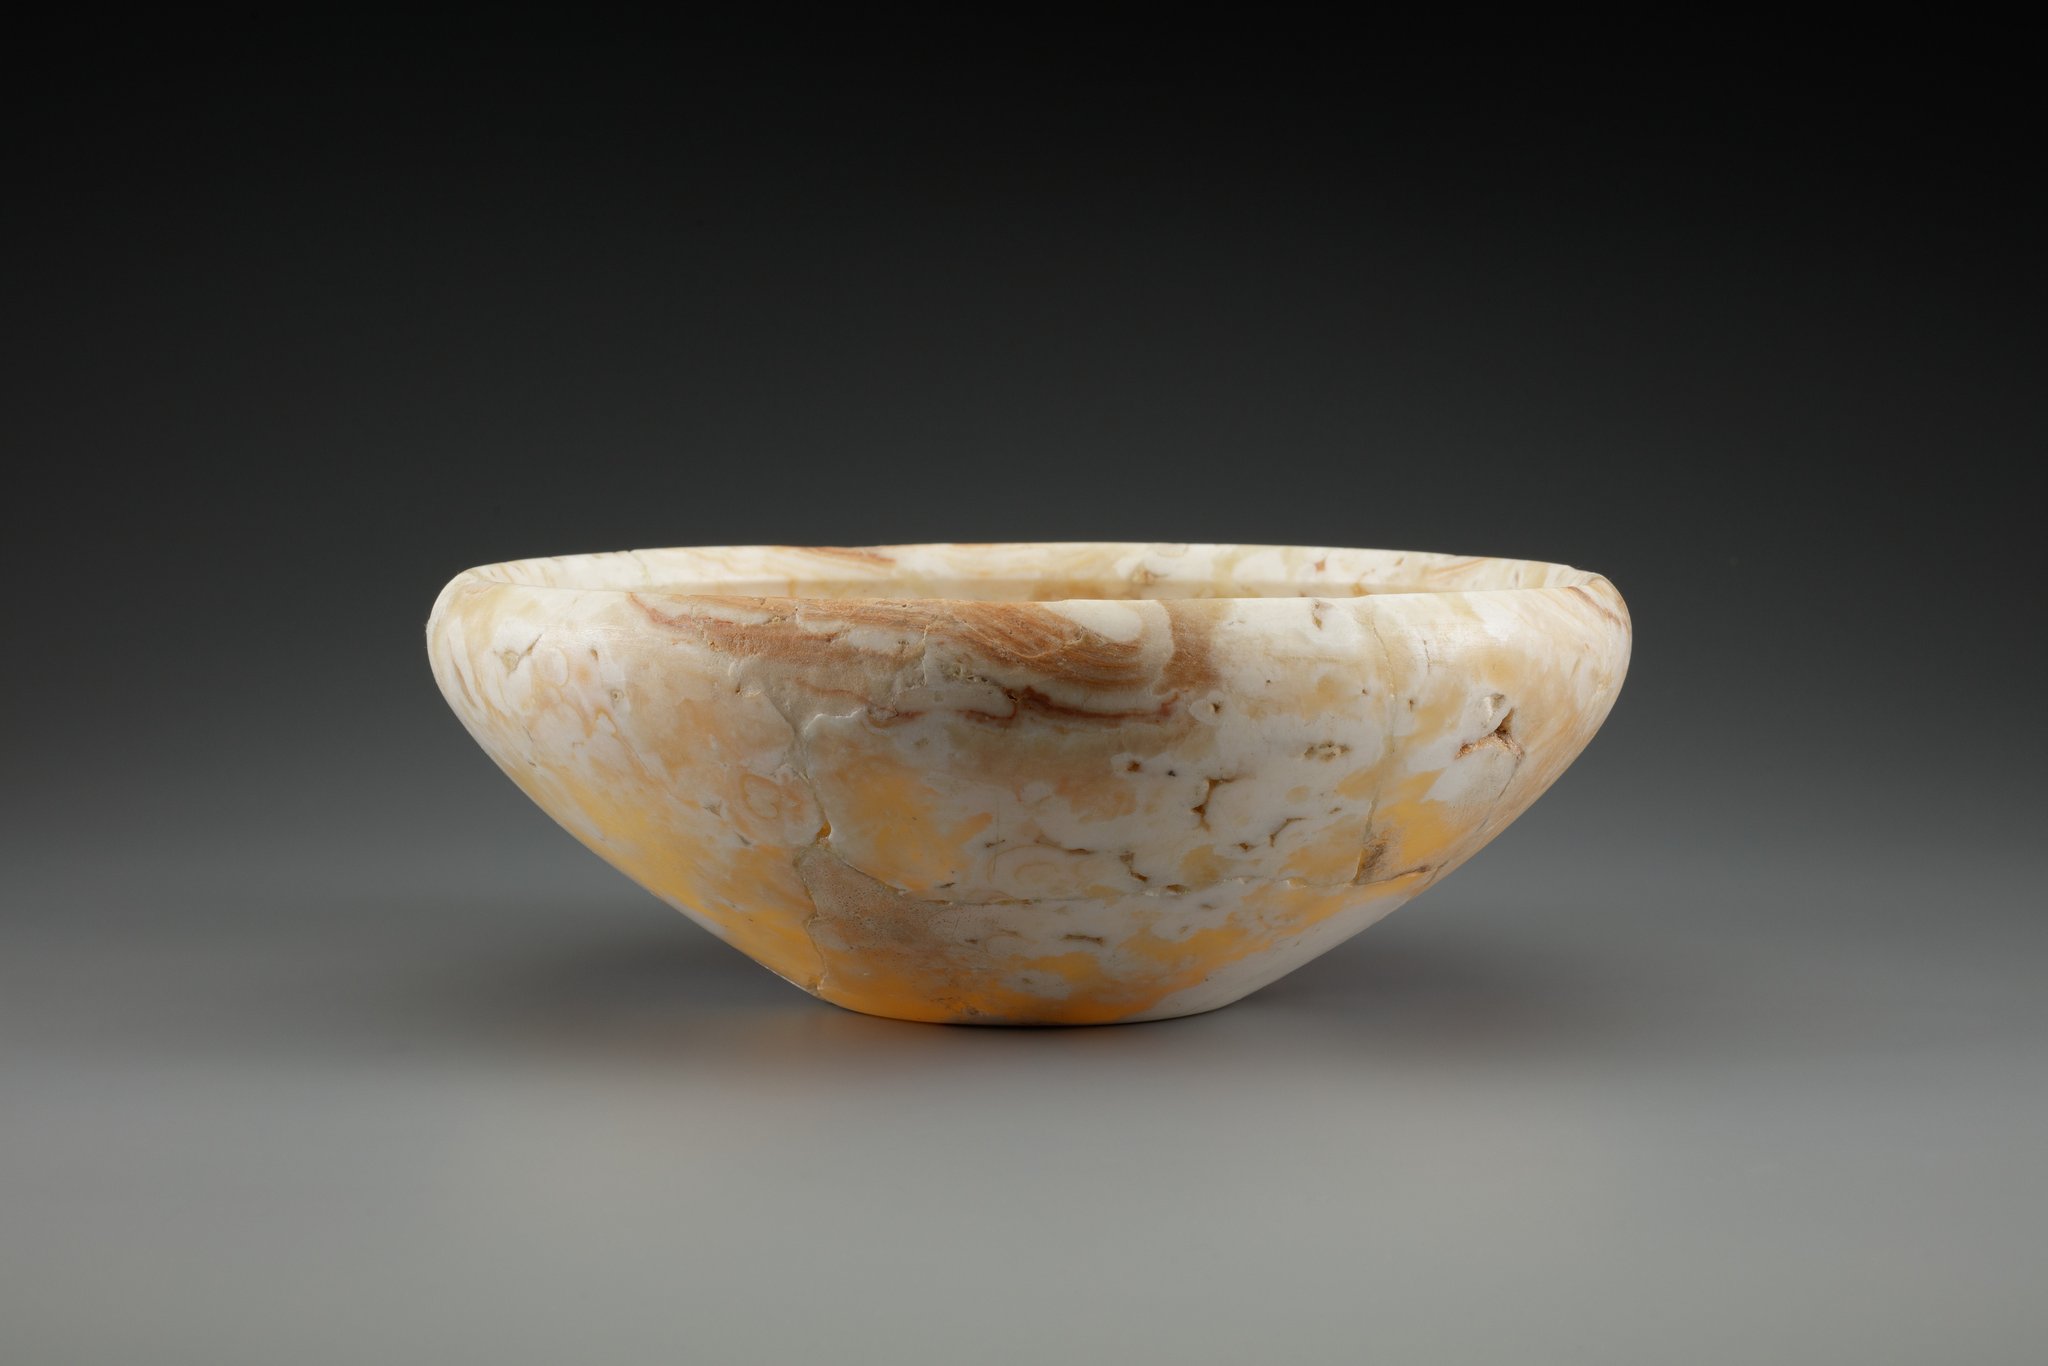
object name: bowl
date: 3100-2649 BCE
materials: stone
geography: egypt